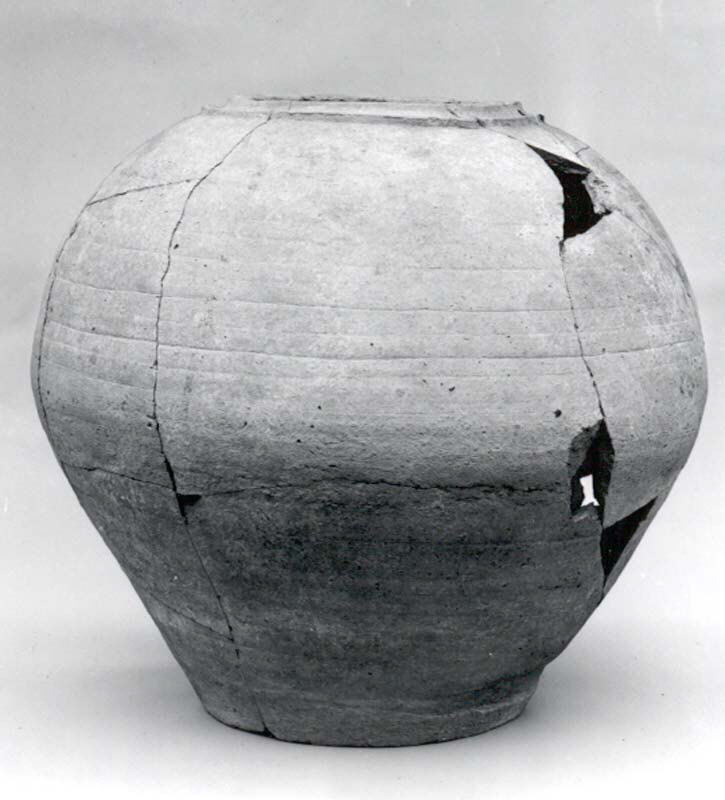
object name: jar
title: Storage jar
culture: sasanian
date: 201-700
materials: ceramic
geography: iran